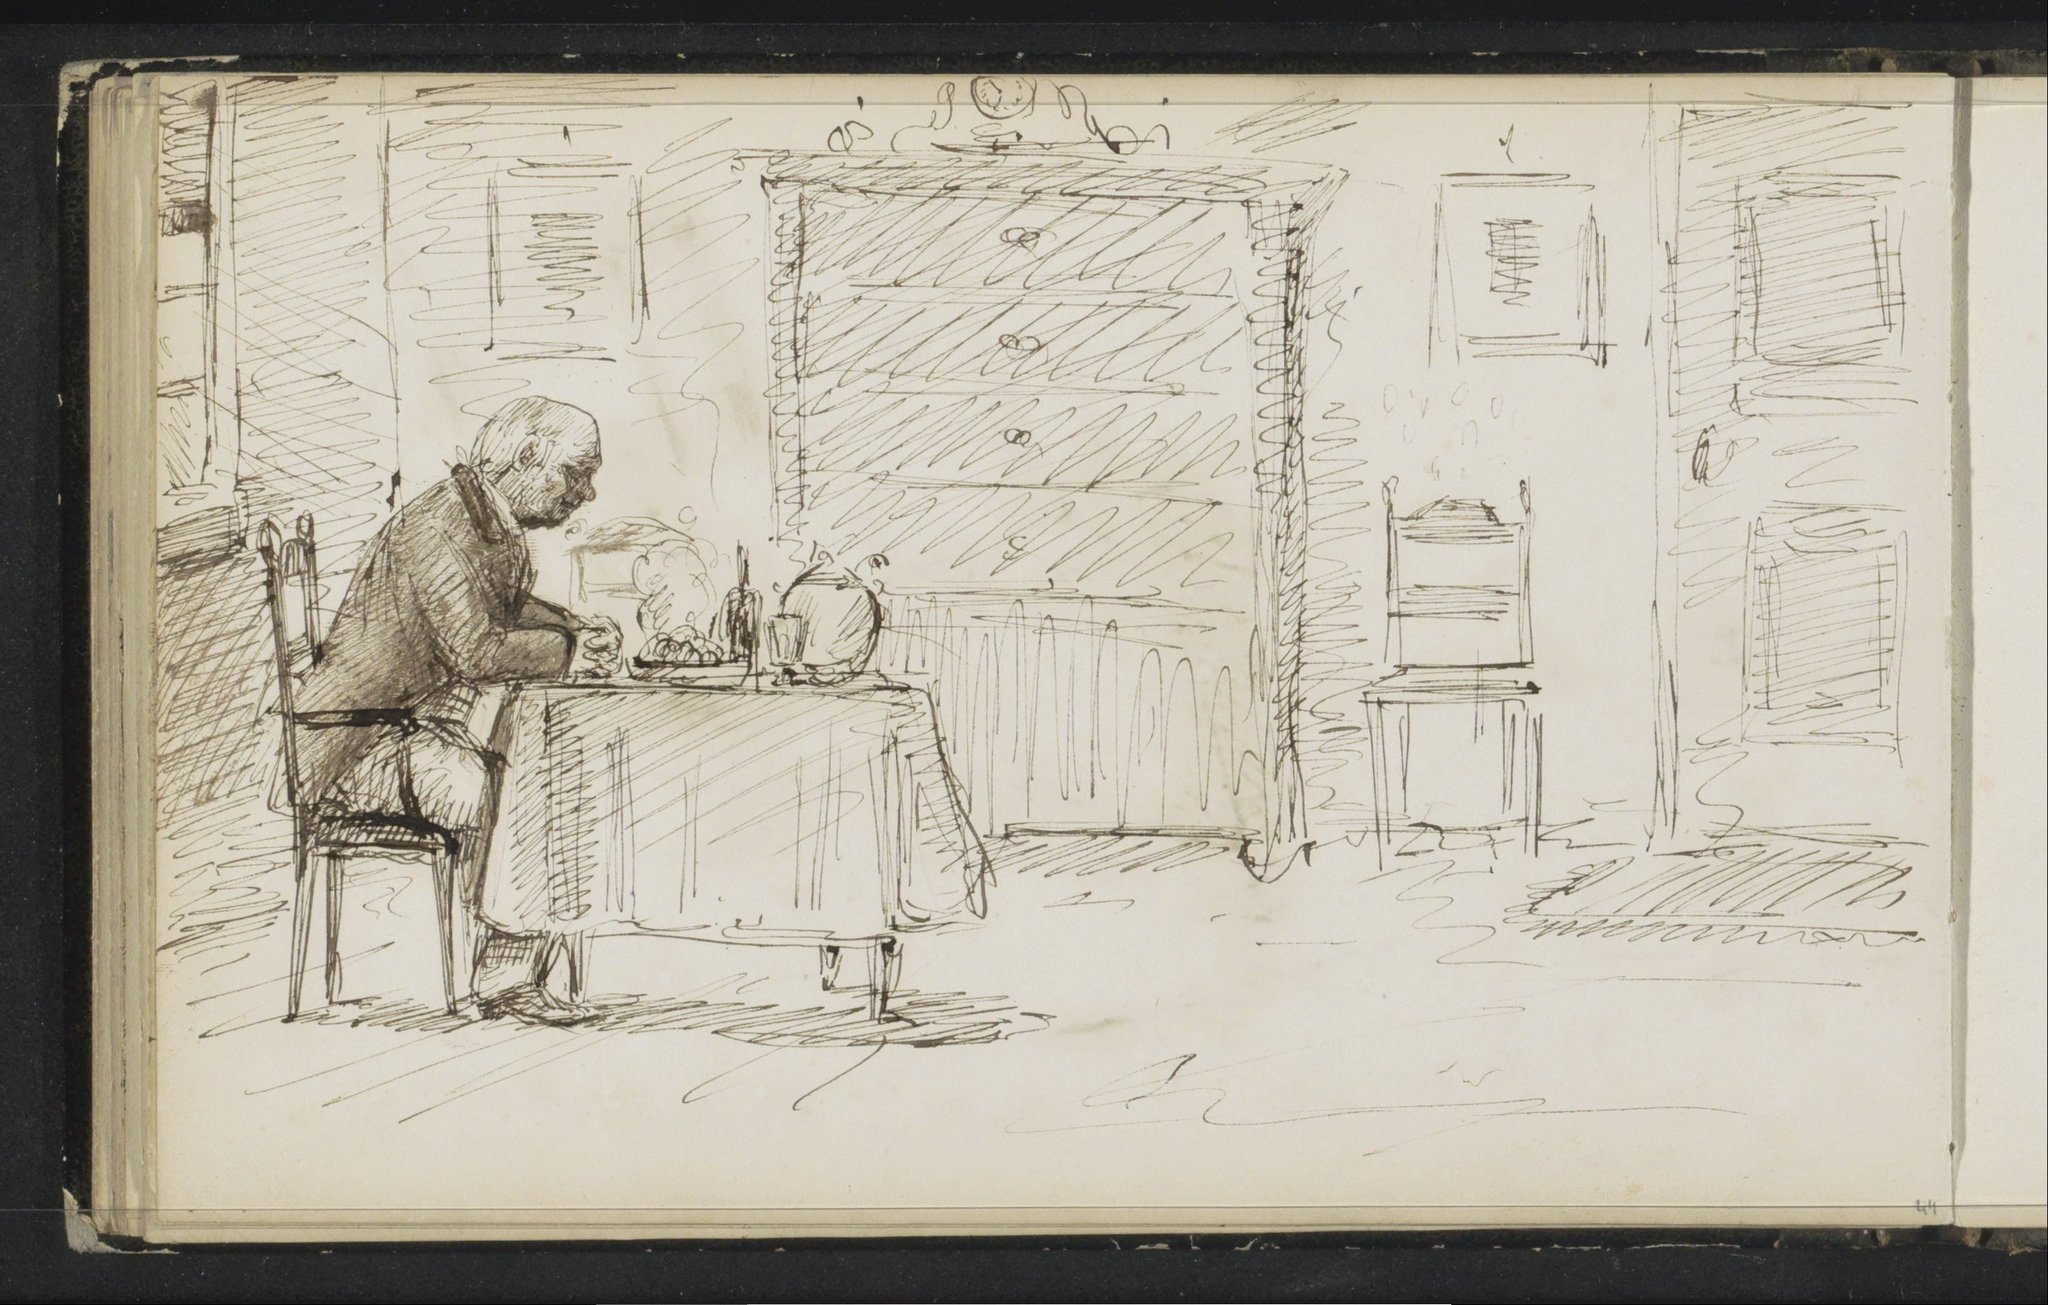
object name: sketchbook leaf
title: Biddende man aan een gedekte tafel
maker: marius bauer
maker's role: draughtsman, print maker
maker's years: 1867-1932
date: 1812-1880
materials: paper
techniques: pen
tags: sitting figure, adult man, interior of the house, prayer at table, saying grace, laid table: table-ware, table-decoration, etc.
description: De man zit met zijn handen gevouwen en bidt mogelijk voor de maaltijd die voor hem op de tafel staat. Pagina 44 uit een schetsboek met 34 bladen.